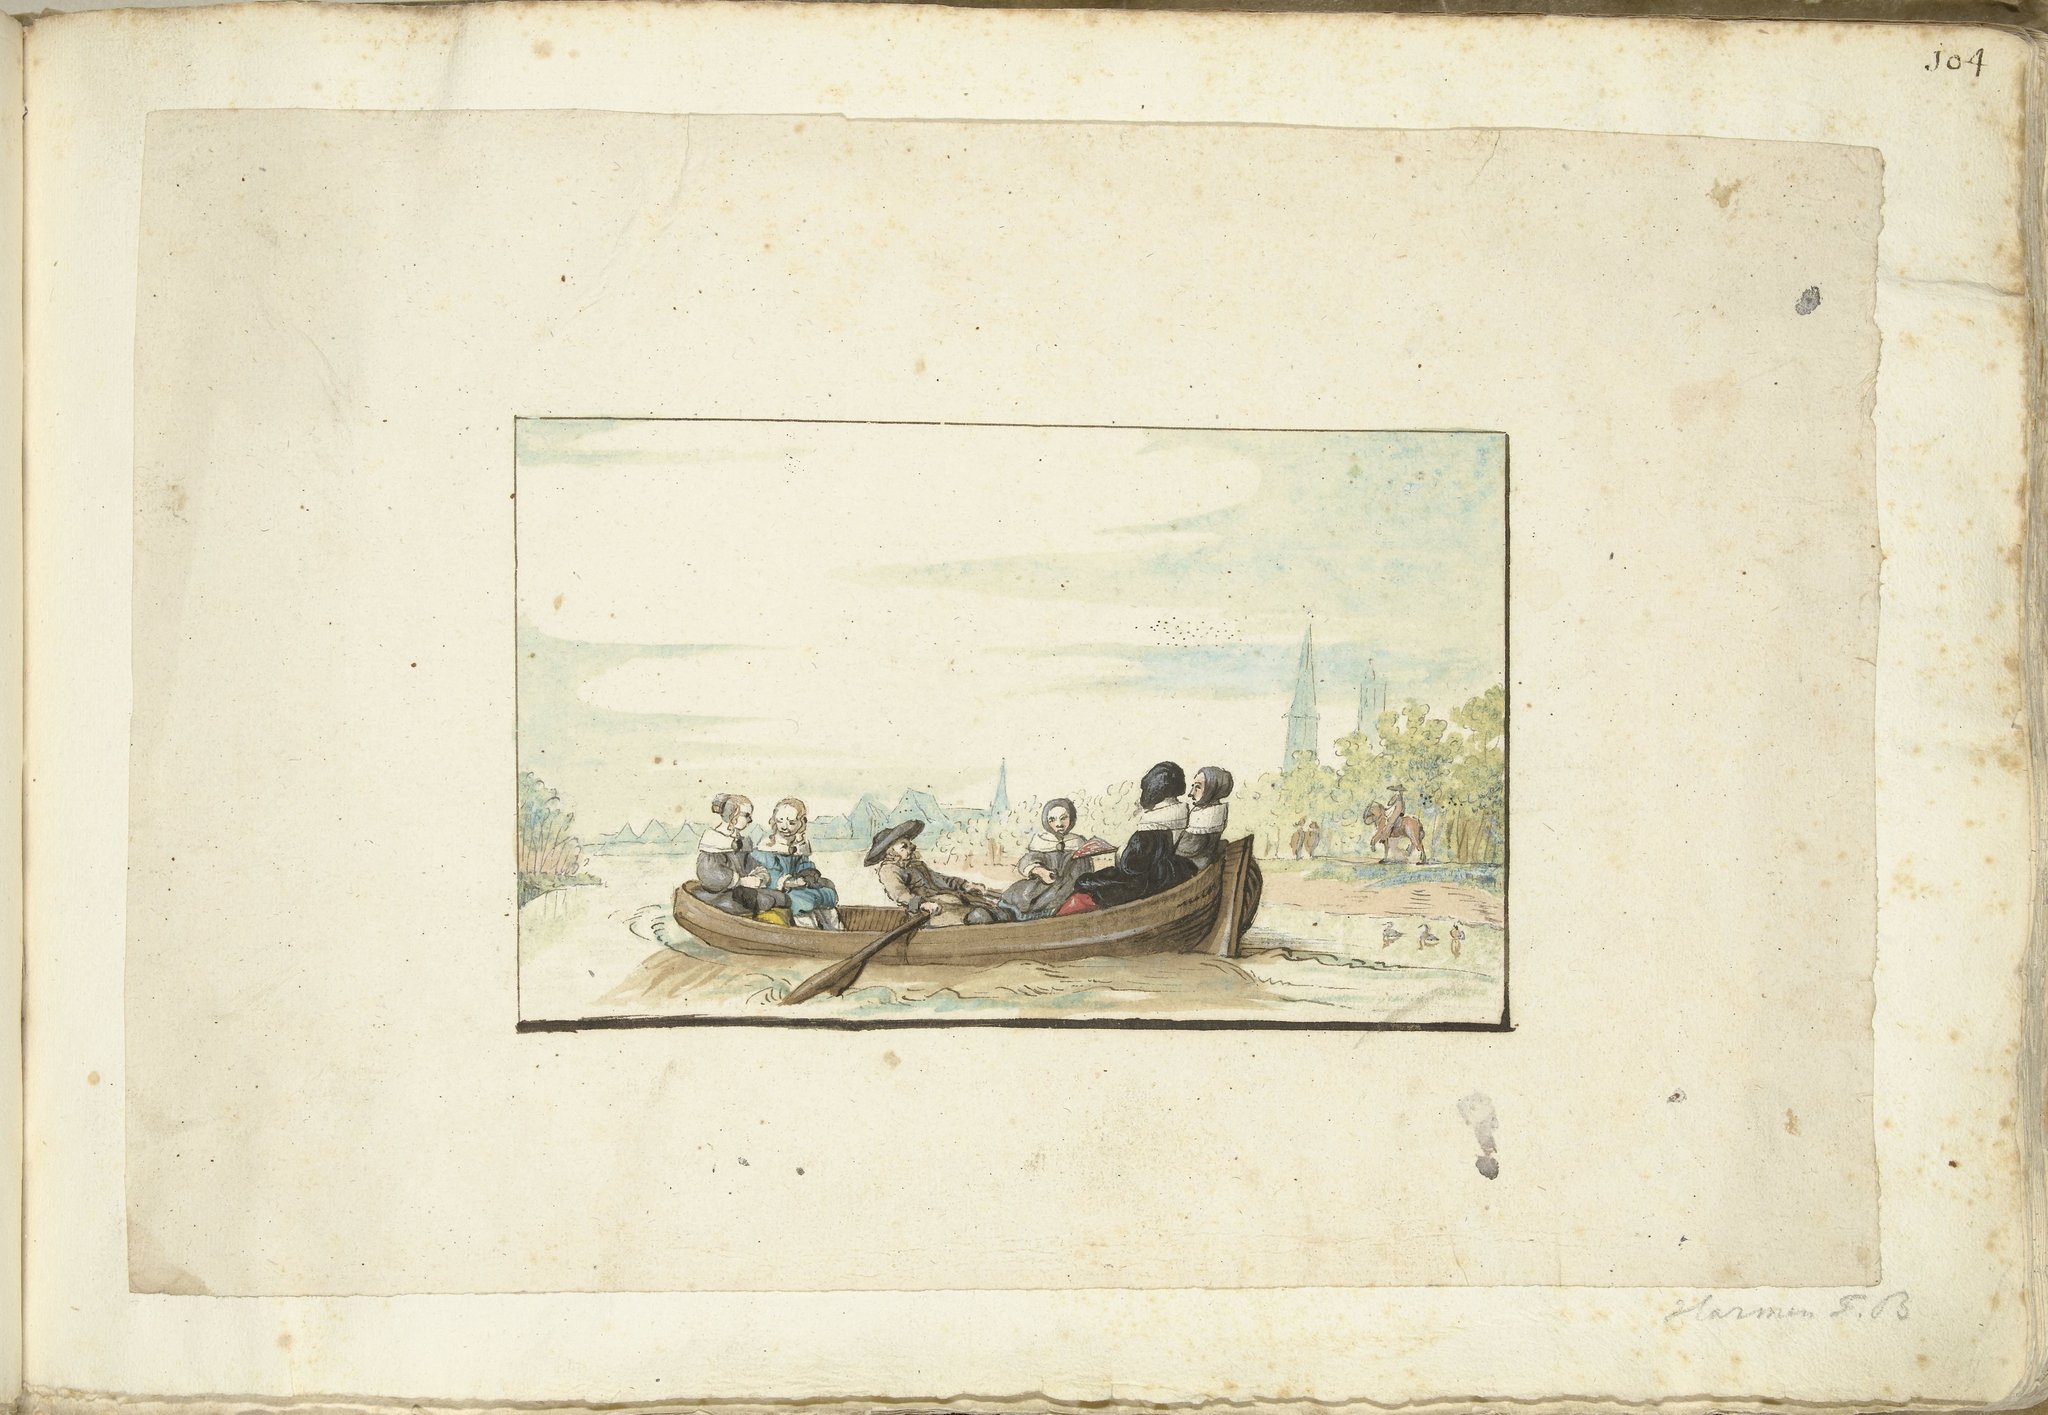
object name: watercolor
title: Gezelschap van zes mensen in een boot op de Zwolse singel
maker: harmen ter borch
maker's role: draughtsman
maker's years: 1638-1677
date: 1655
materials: paper, watercolor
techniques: brush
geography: zwolle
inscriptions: annotation: ‘Harmen T.B’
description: Gezelschap van zes mensen in een boot op de Zwolse singel. In de verte zijn de torens van de Sint-Michaëlskerk en de Onze Lieve Vrouwe Kerk te zien.